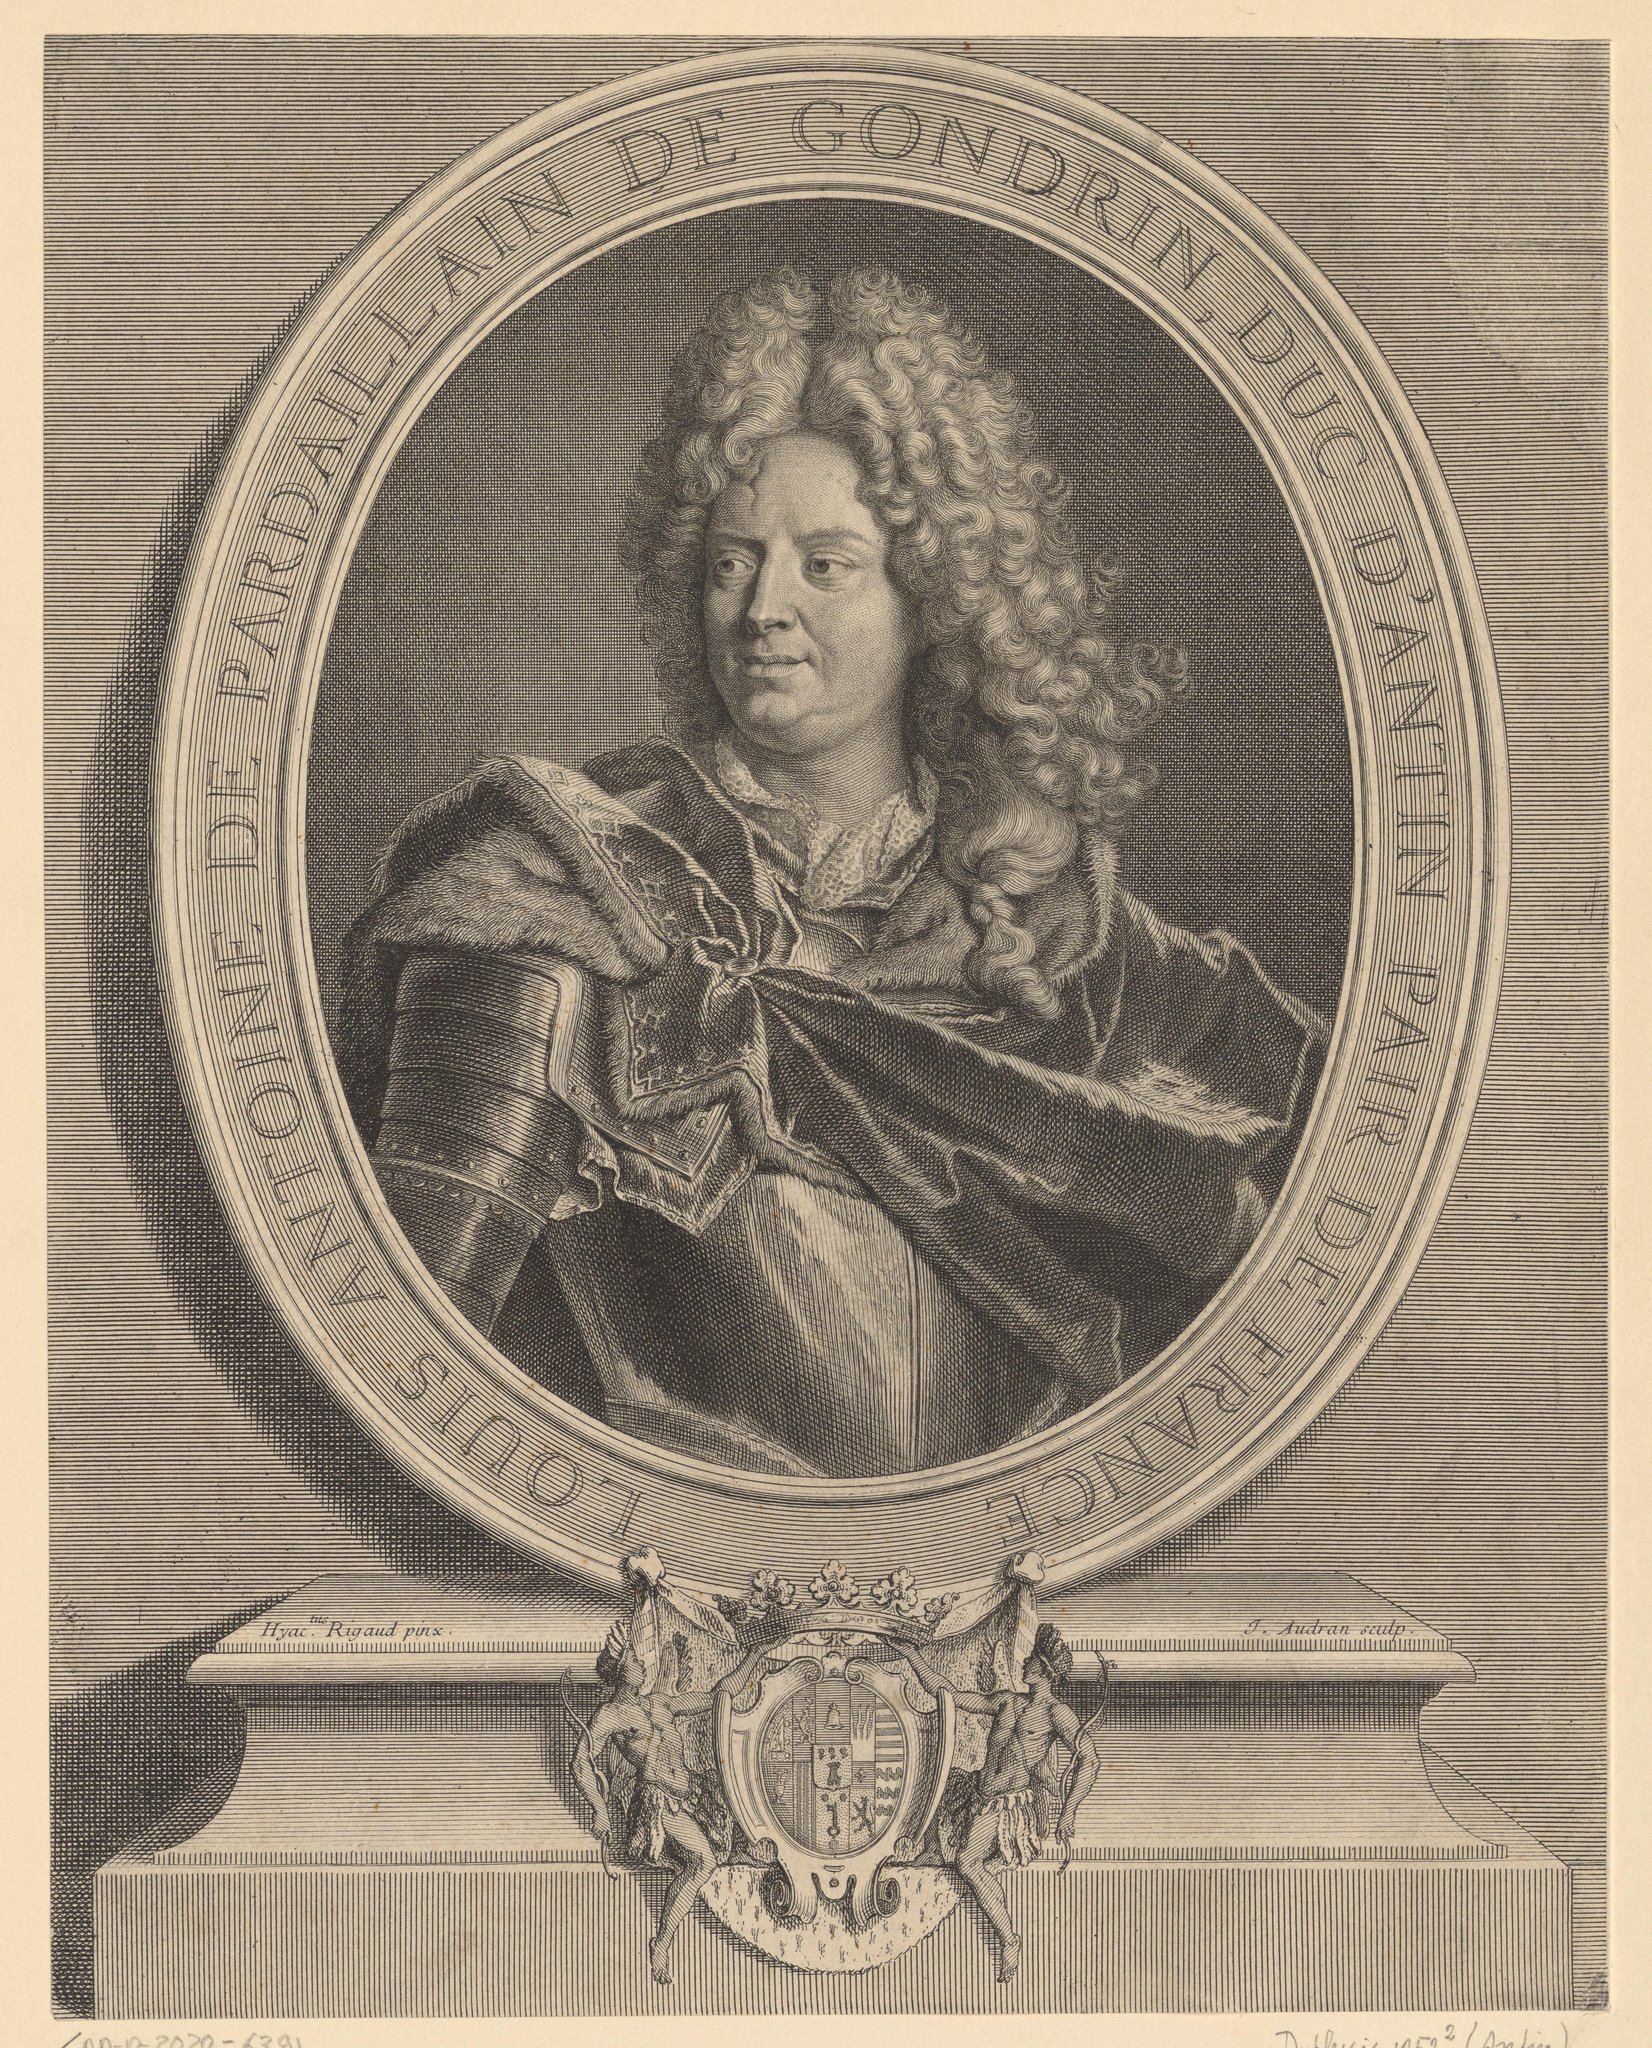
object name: print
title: Portret van Louis Antoine de Pardaillan de Gondrin, eerste hertog van Antin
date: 1710-1756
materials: paper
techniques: engraving, etching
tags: louis antoine de pardaillan de gondrin (eerste hertog van antin), ornaments ~ art (+ framing decorations), historical persons, diplomacy, diplomat, native peoples of the americas